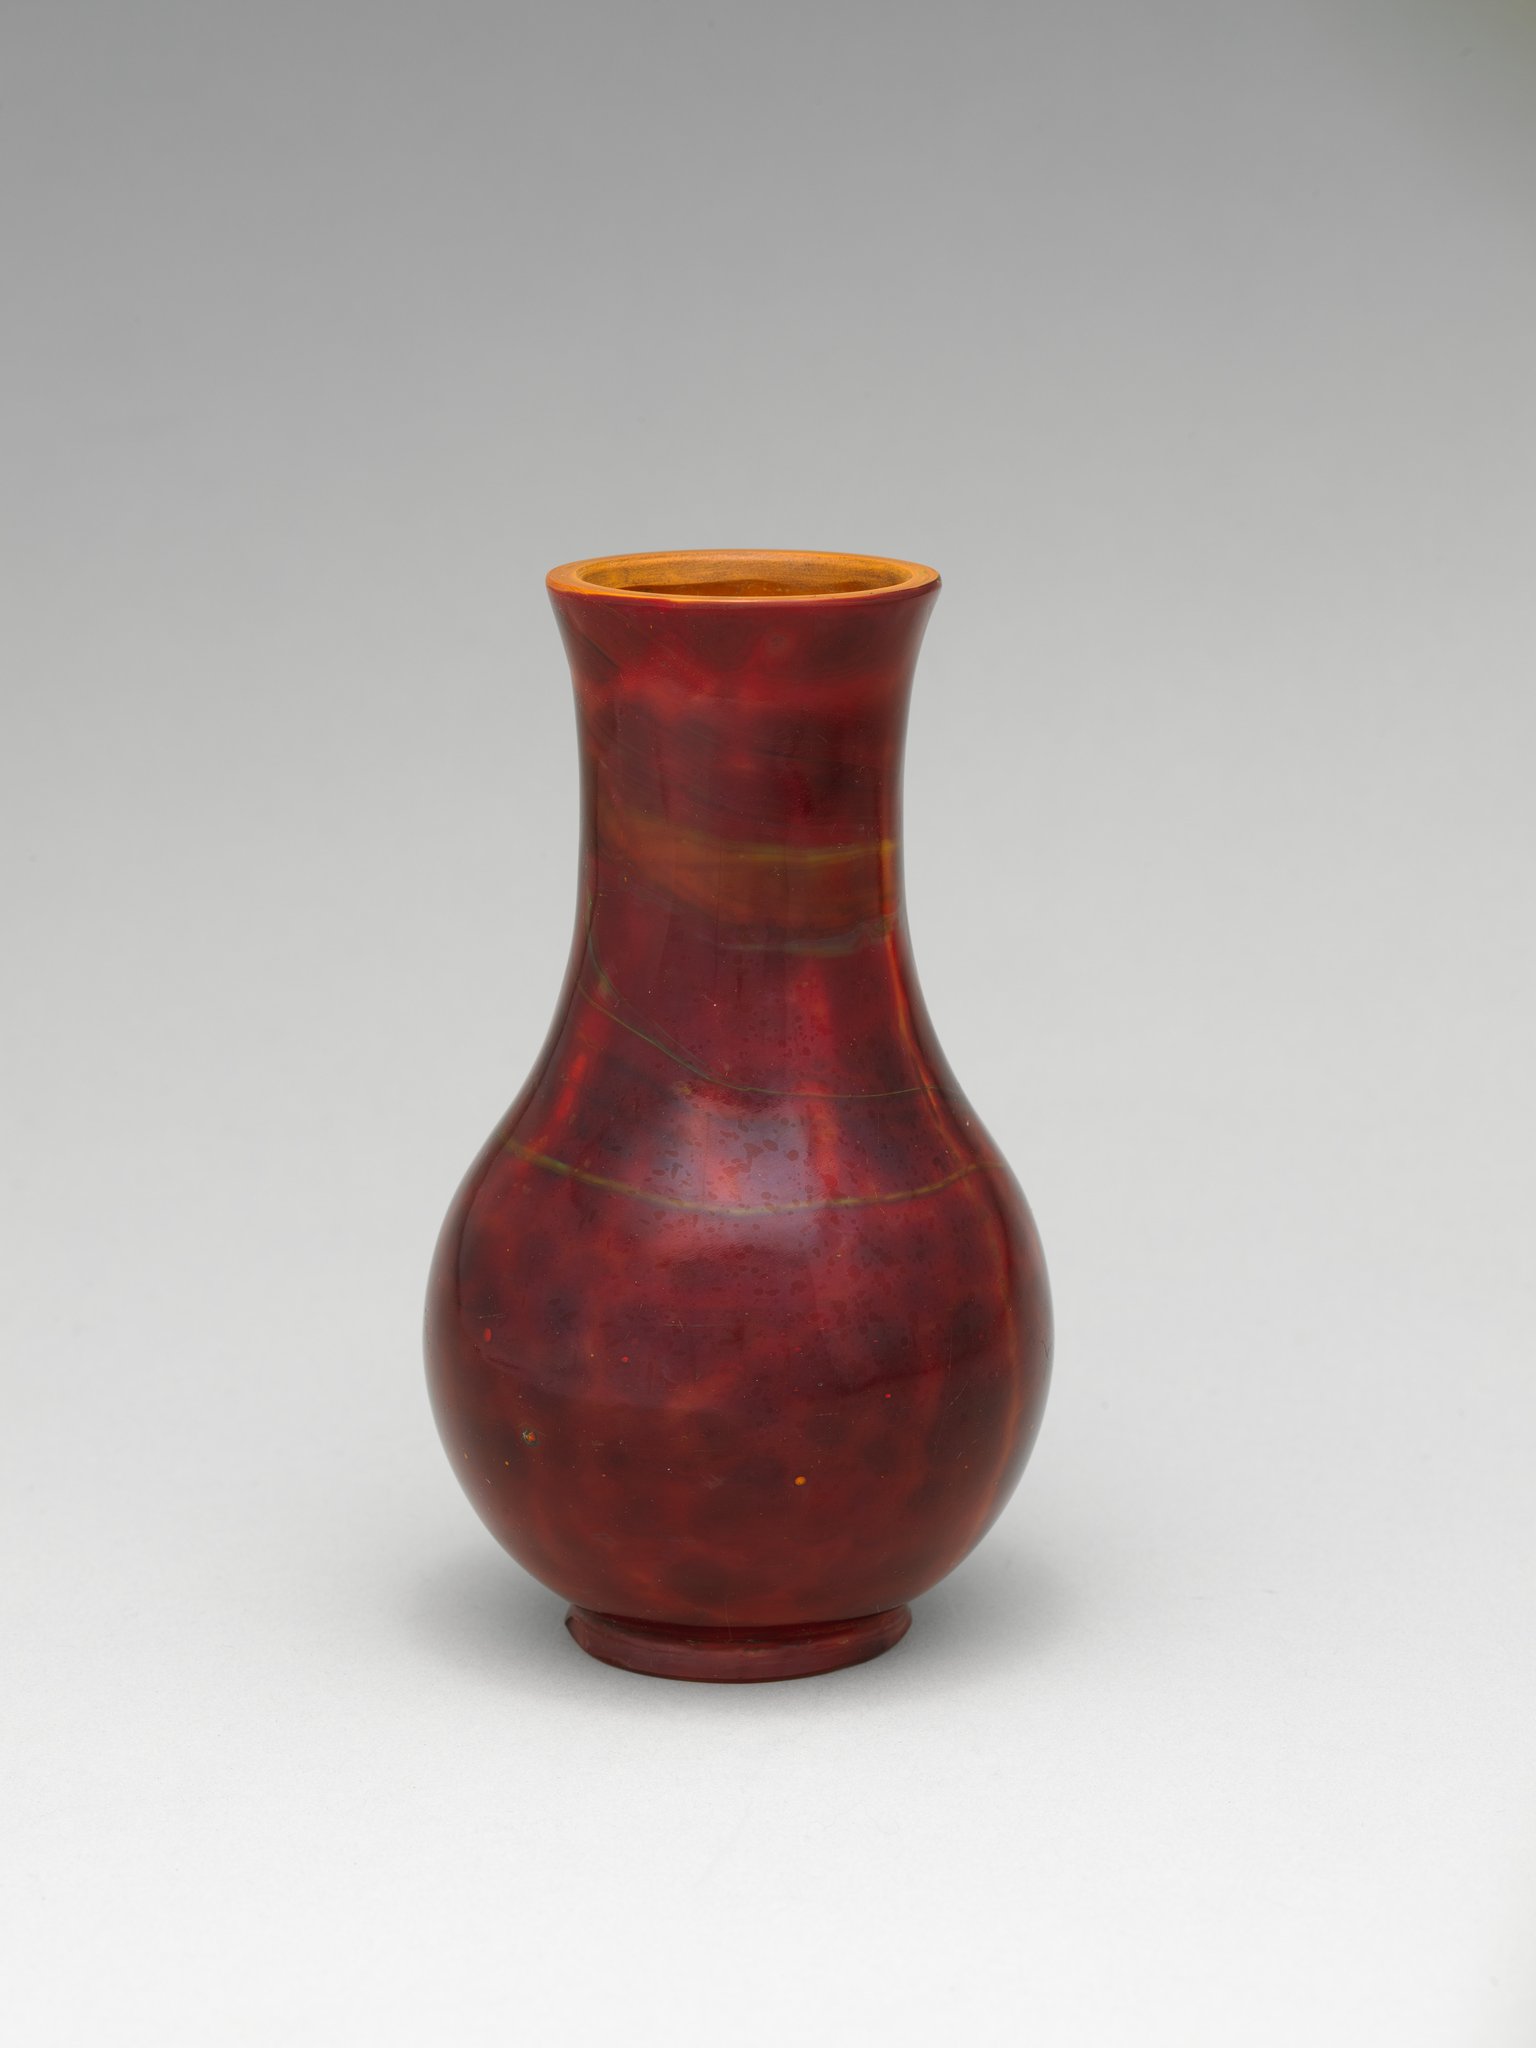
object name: vase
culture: chinese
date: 1801-1833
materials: glass